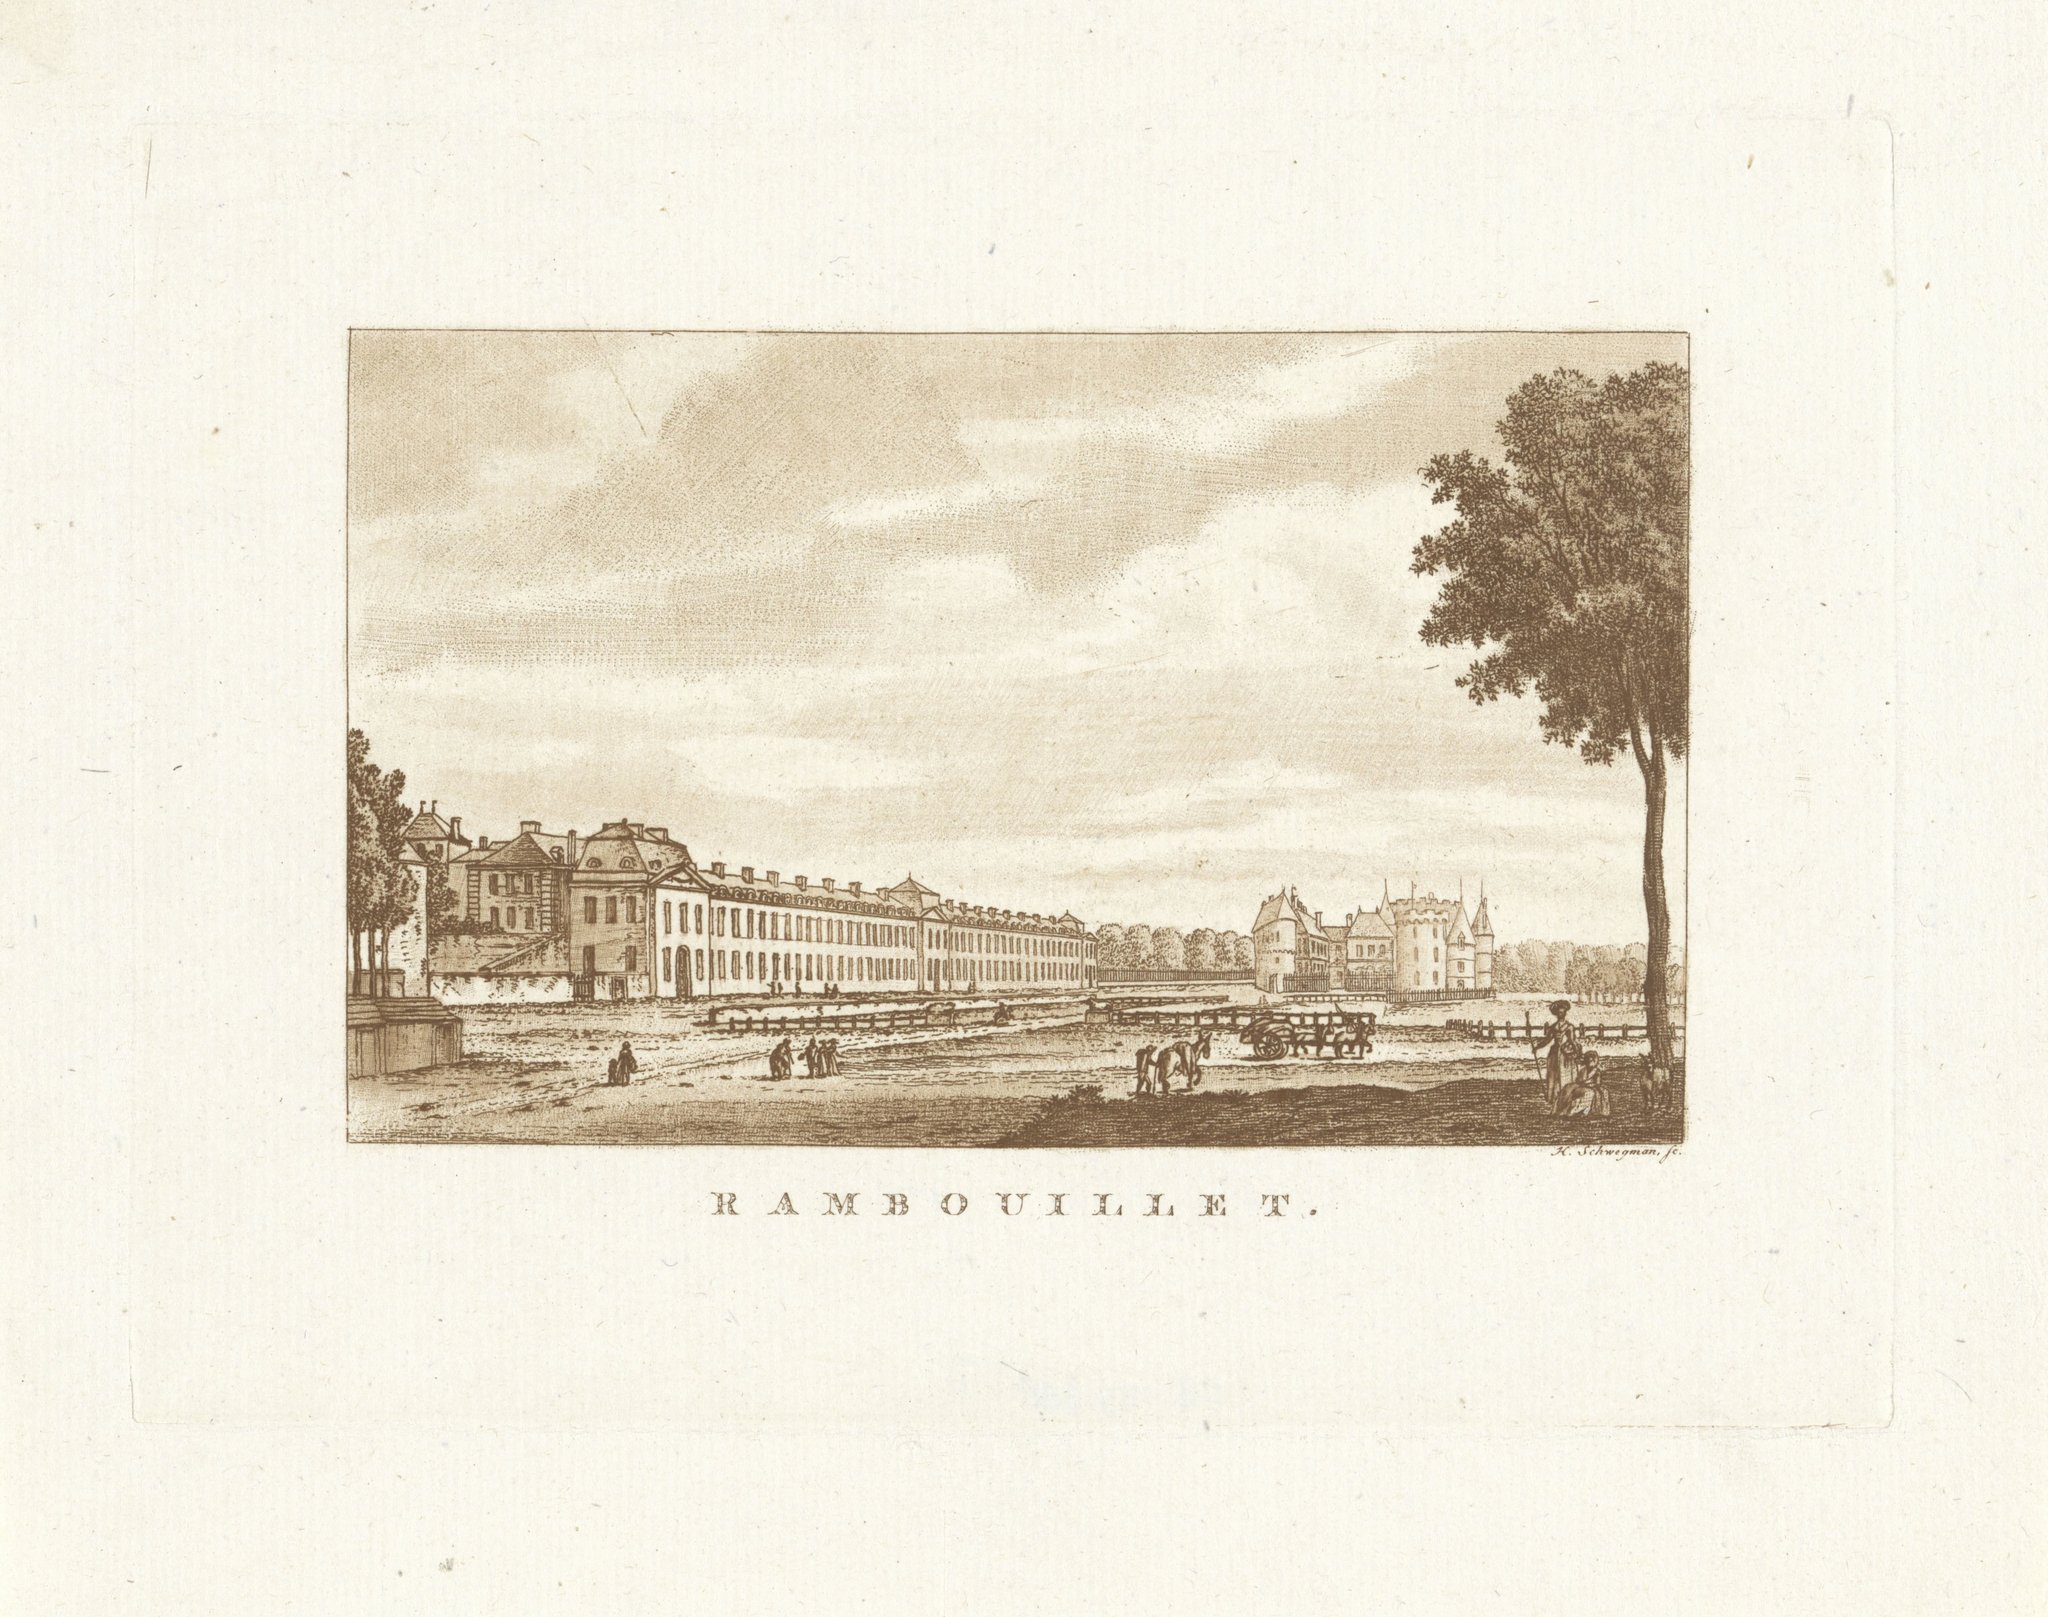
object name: print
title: Rambouillet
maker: hendrik schwegman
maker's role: draughtsman, print maker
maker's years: 1761-1816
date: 1771-1816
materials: paper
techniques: etching, roulette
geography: haarlem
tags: castle, village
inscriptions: collector's mark: Lugt 2228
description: Gezicht op Rambouillet met rechts het kasteel van Rambouillet.